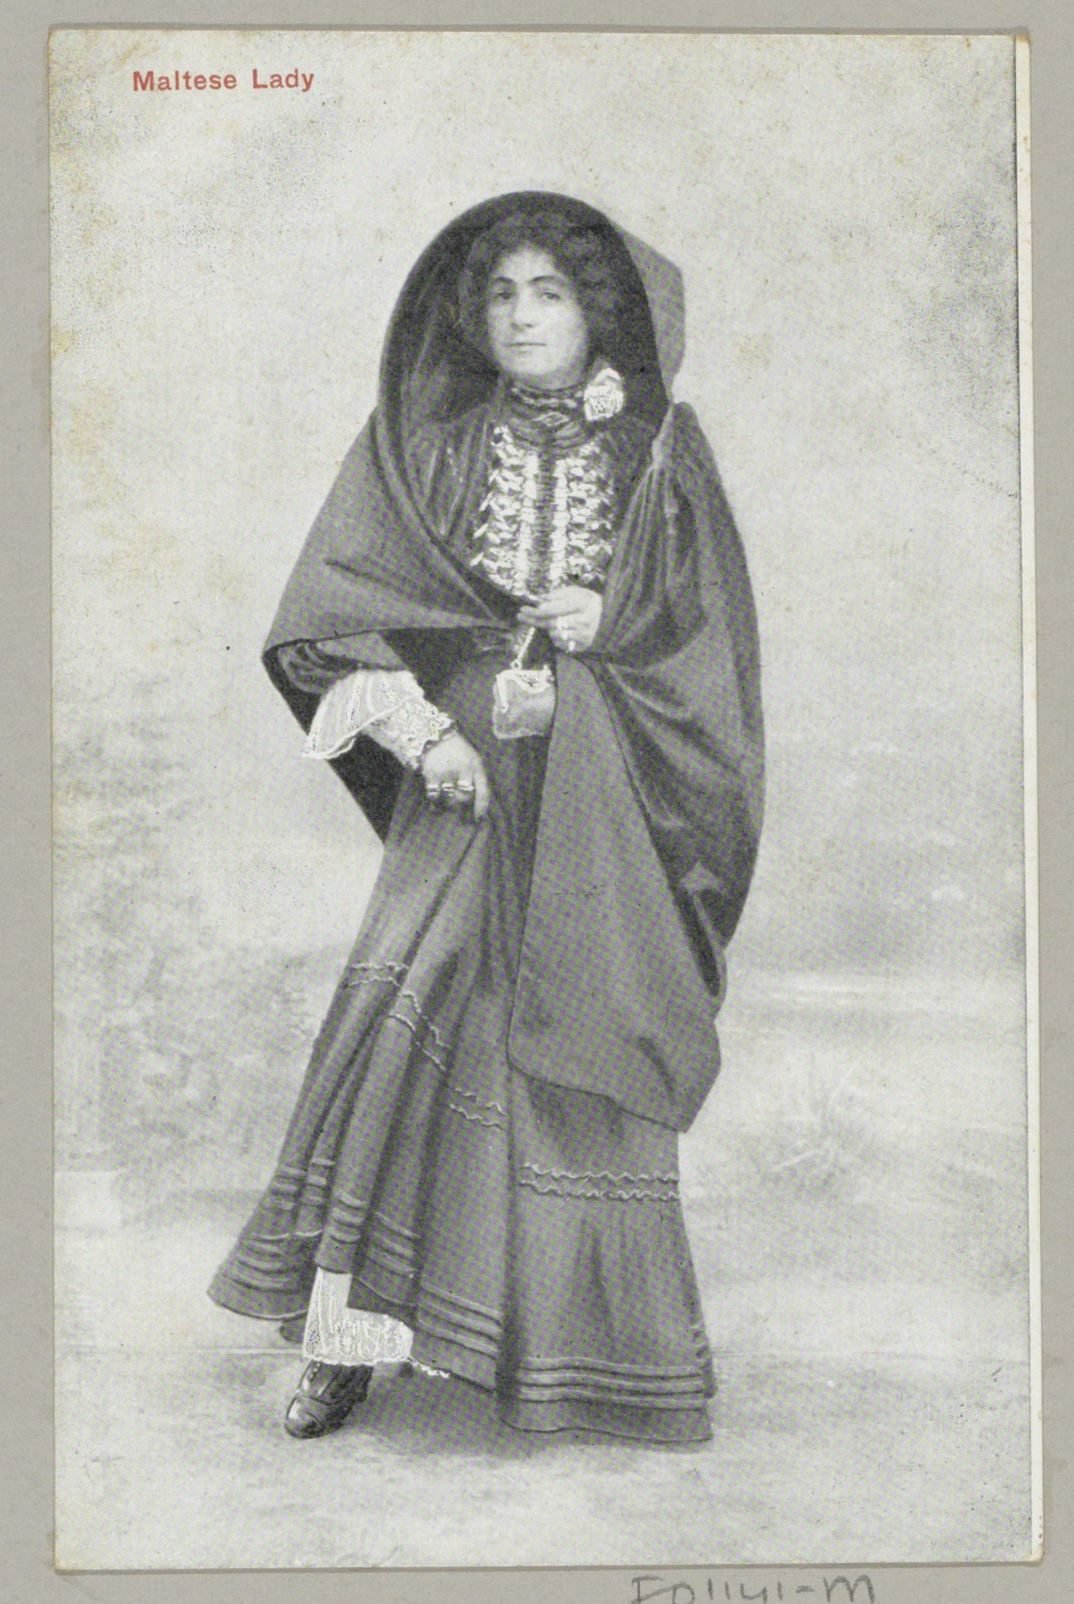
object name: photomechanical print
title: Portret van een Maltezer vrouw met capuchon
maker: Anonymous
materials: paper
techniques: autotype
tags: adult woman, head-gear: hood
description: Onderdeel van Fotoalbum van een reis door Zuid-Europa en het Midden-Oosten.